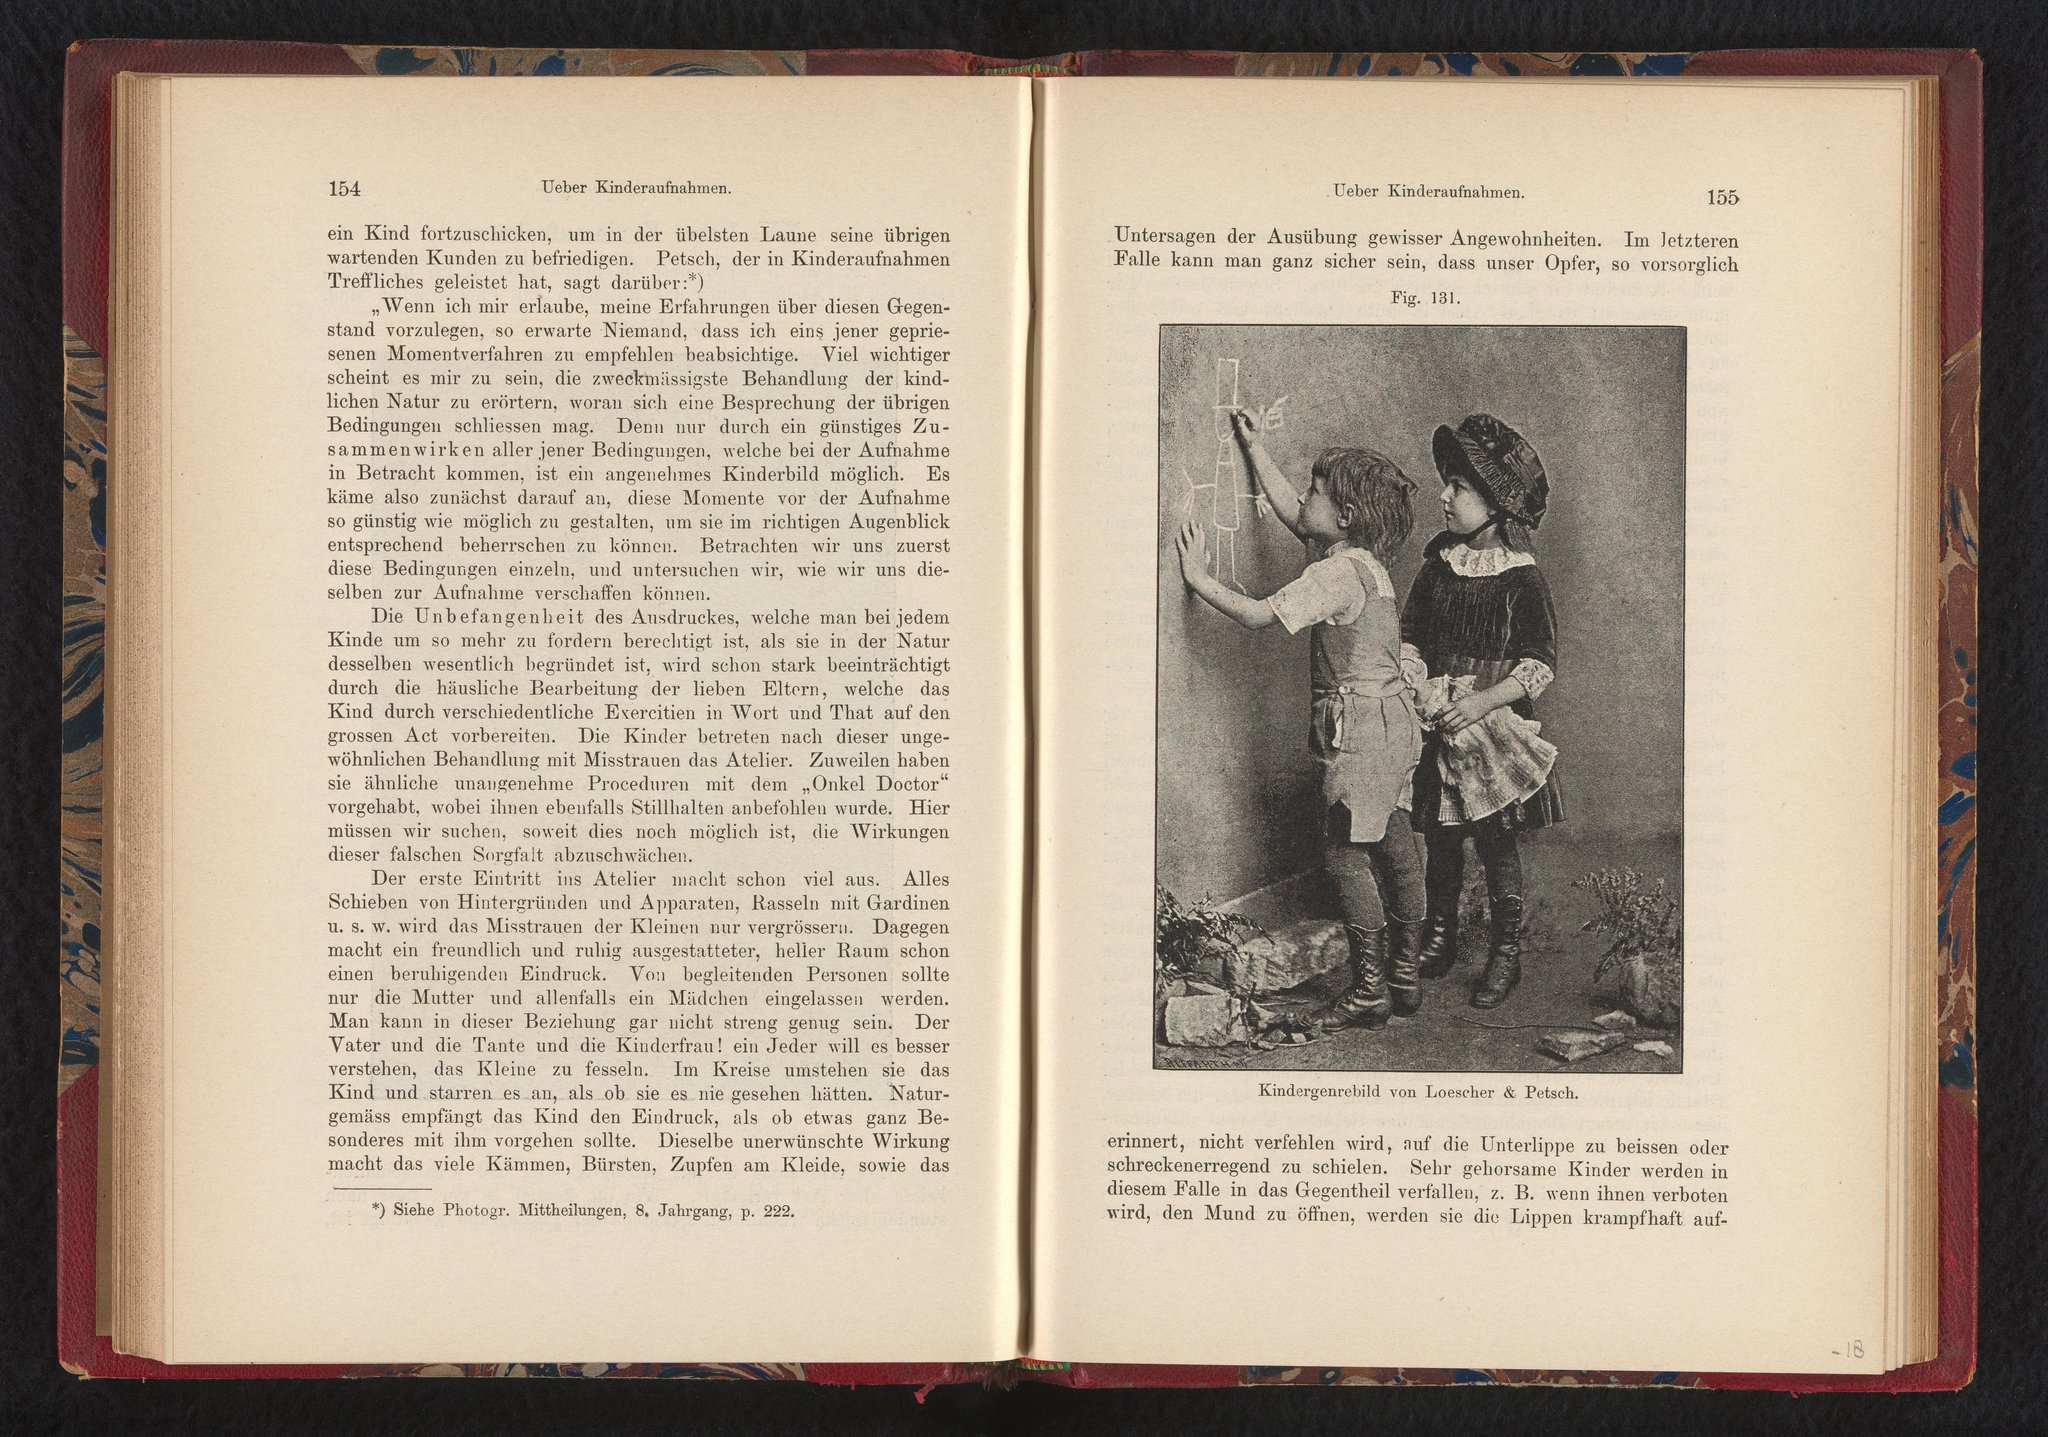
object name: page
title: Portret van een jongen die op een muur tekent en een meisje met pop ernaast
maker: heinrich riffarth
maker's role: printer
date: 1886-1891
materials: paper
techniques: autotype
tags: drawing, child between toddler and youth (of undetermined sex), historical persons not known by name